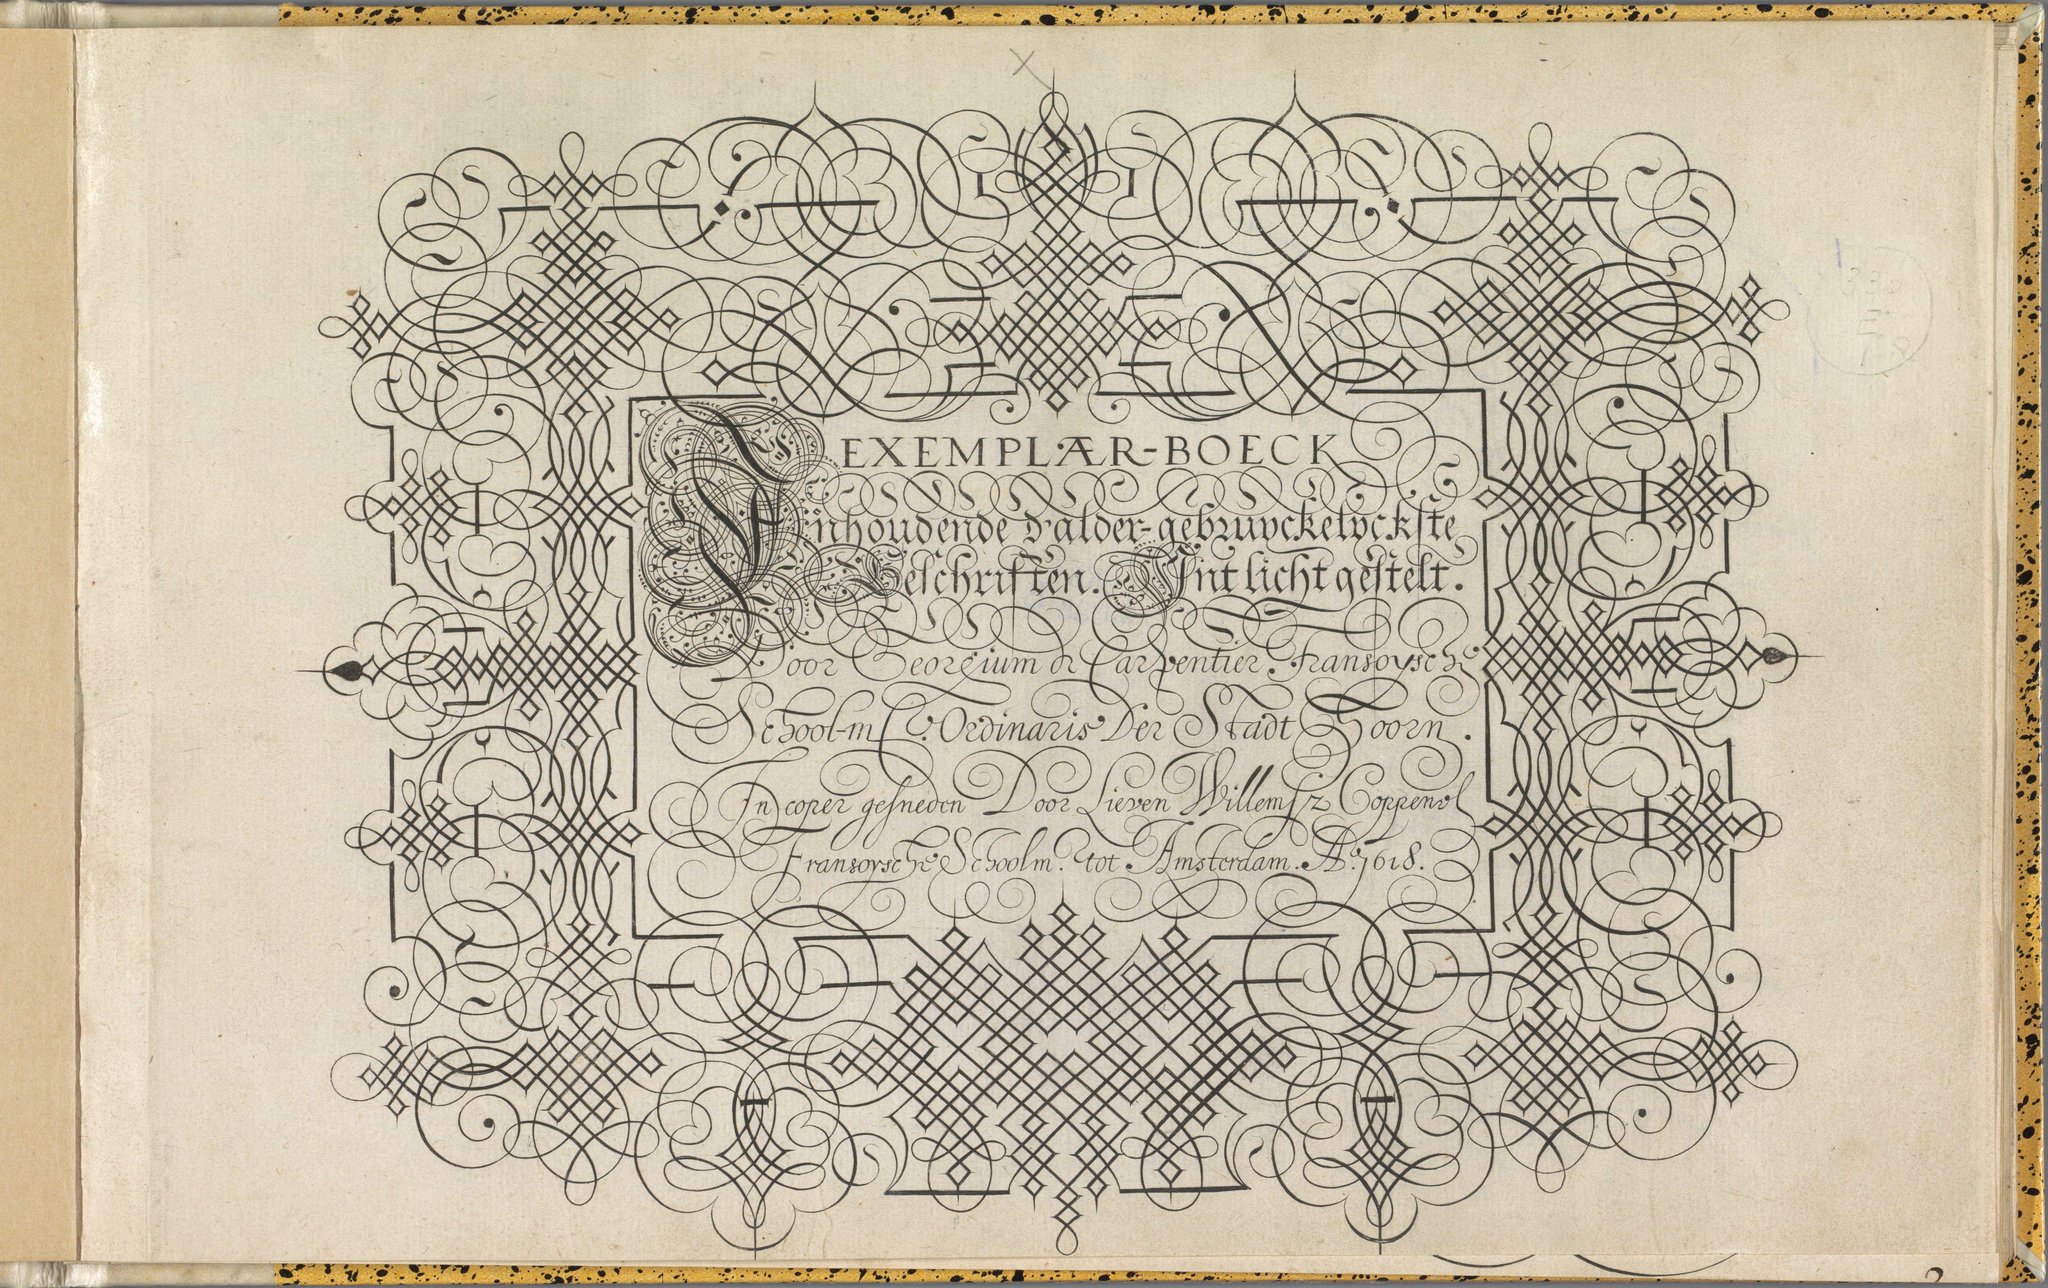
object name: ornament print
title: Titelprent voor een serie kalligrafie voorbeelden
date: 1618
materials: paper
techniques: engraving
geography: amsterdam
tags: ornament ~ moresque, calligraphy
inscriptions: collector's mark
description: De serietitel in schoonschrift in een kader van krullen en moresken. Deze prent maakt deel uit van een album.